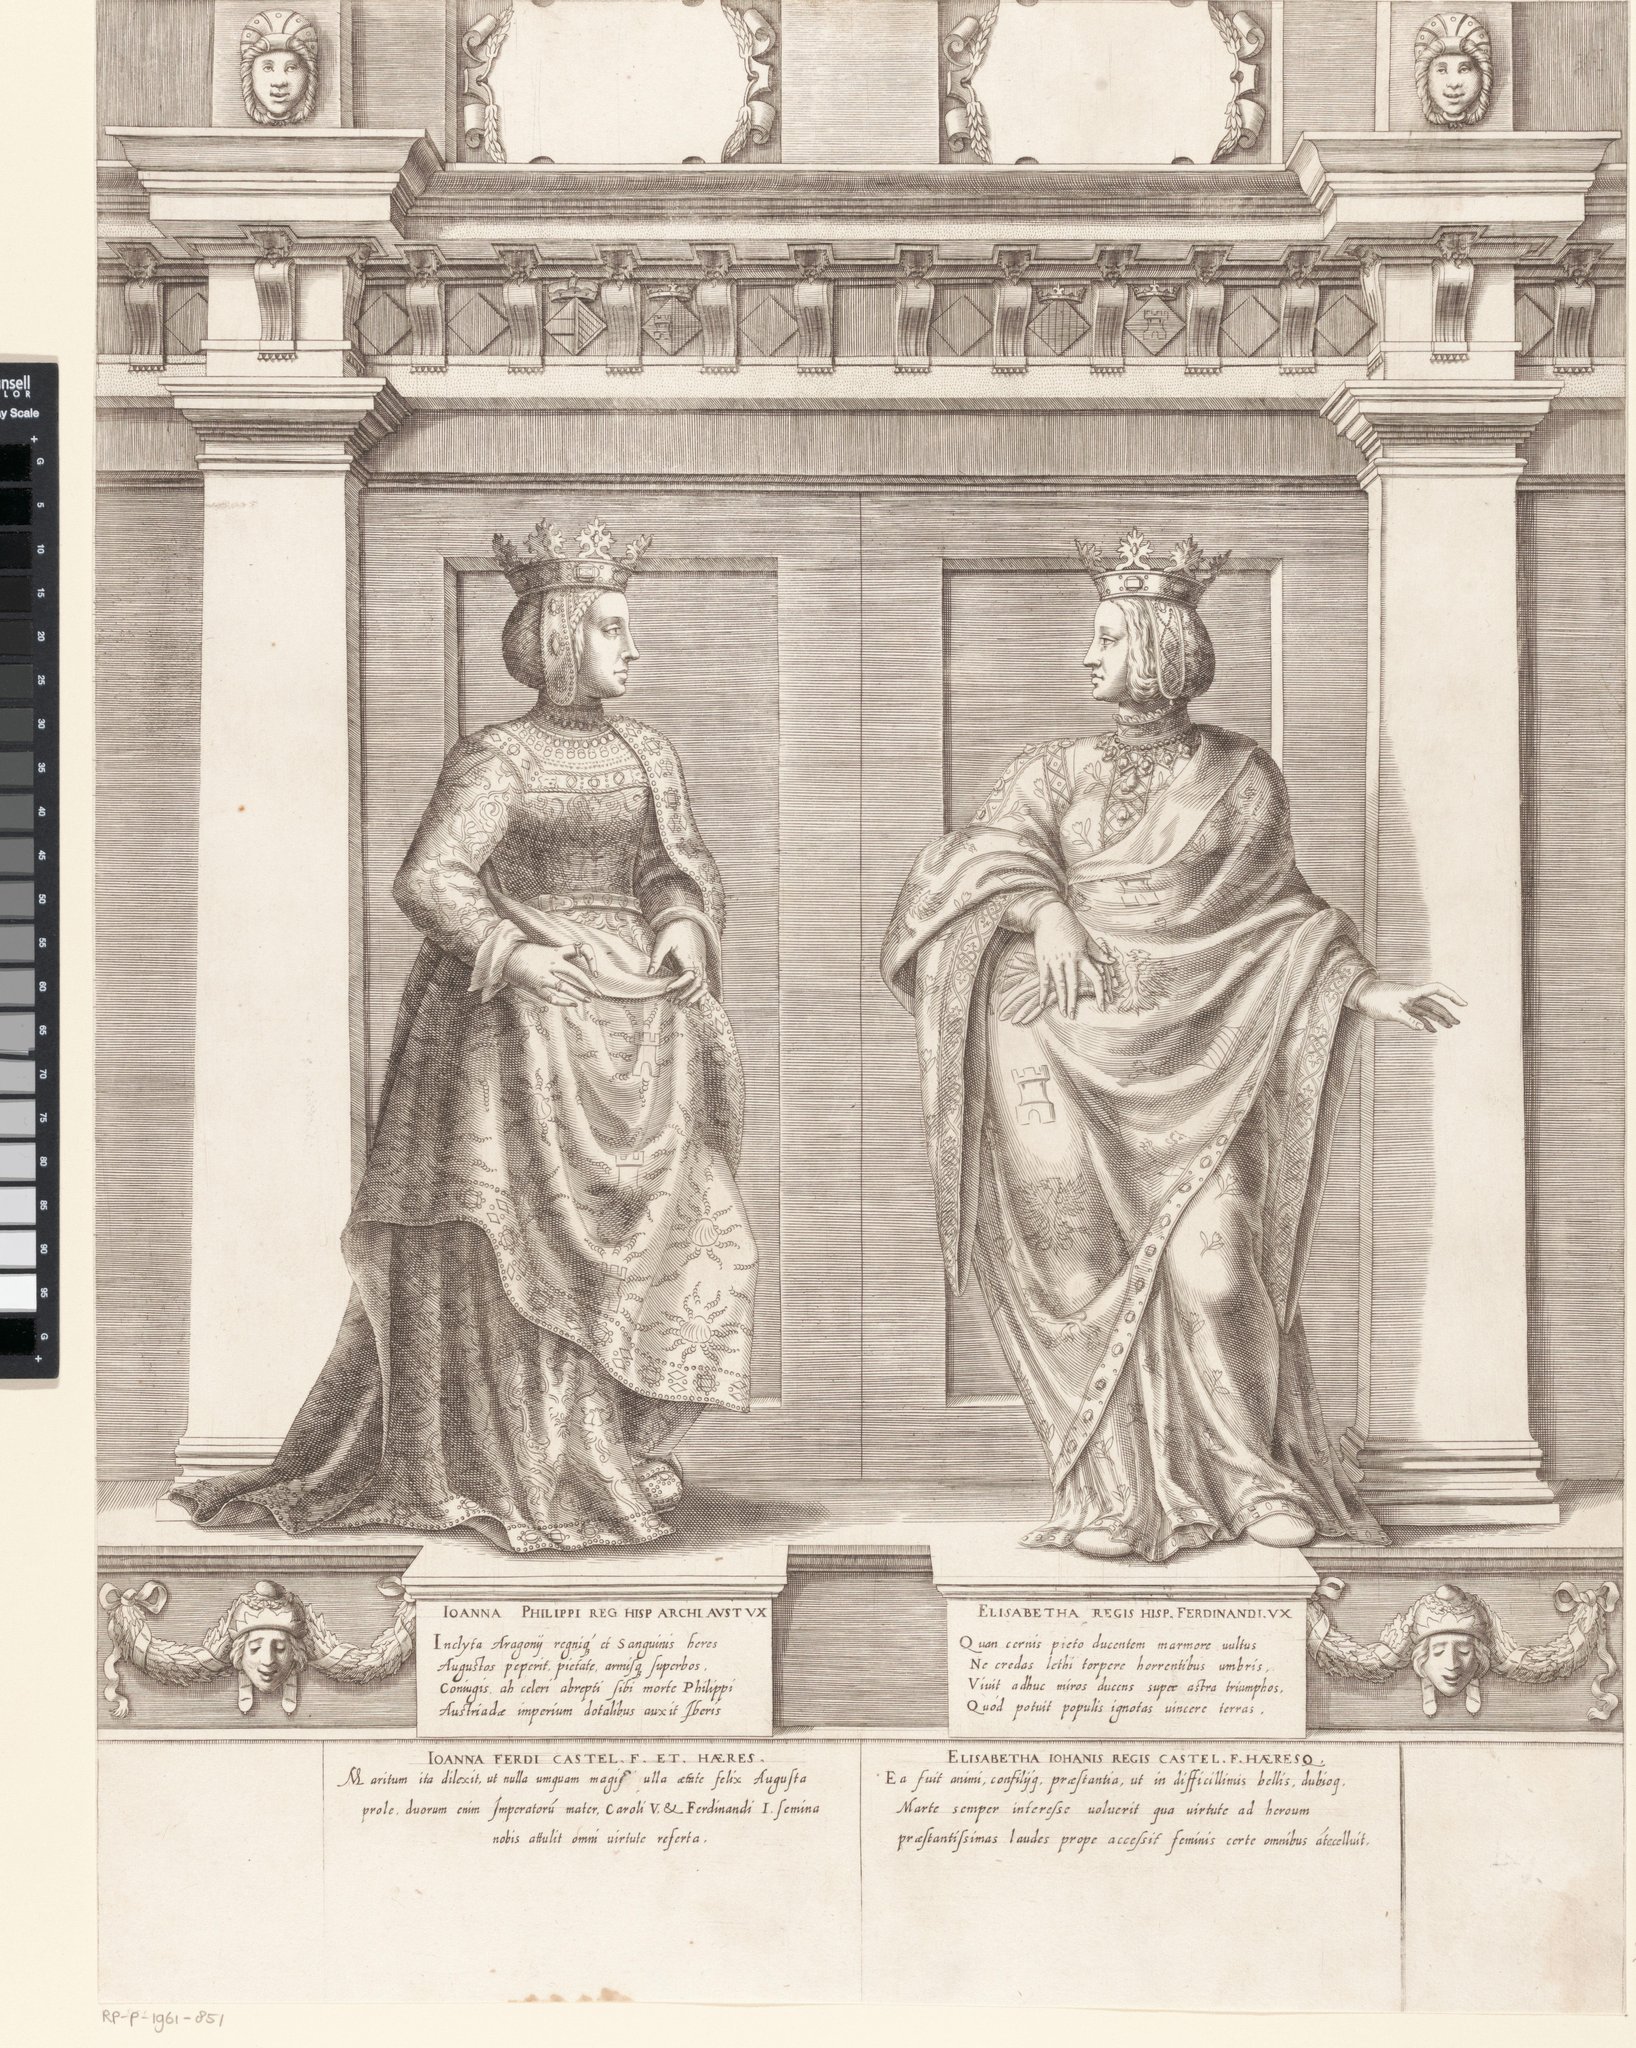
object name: print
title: Austriacae gentis imaginum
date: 1569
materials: paper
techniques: engraving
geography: italy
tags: historical persons - bb - woman, ruler, sovereign - bb - female ruler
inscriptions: collector's mark: Lugt 2228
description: Deze prent maakt deel uit van een reeks van 58 prenten. Het meerendeel van de prenten bevat portretten van 74 leden van het Oostenrijkse Huis, naar tekeningen door Francesco Terzio, die deels getekend zijn naar de 28 levensgrote bronzen beelden die rond de cenotaaf van Maximiliaan I in de Hofkirche te Innsbruck staan.